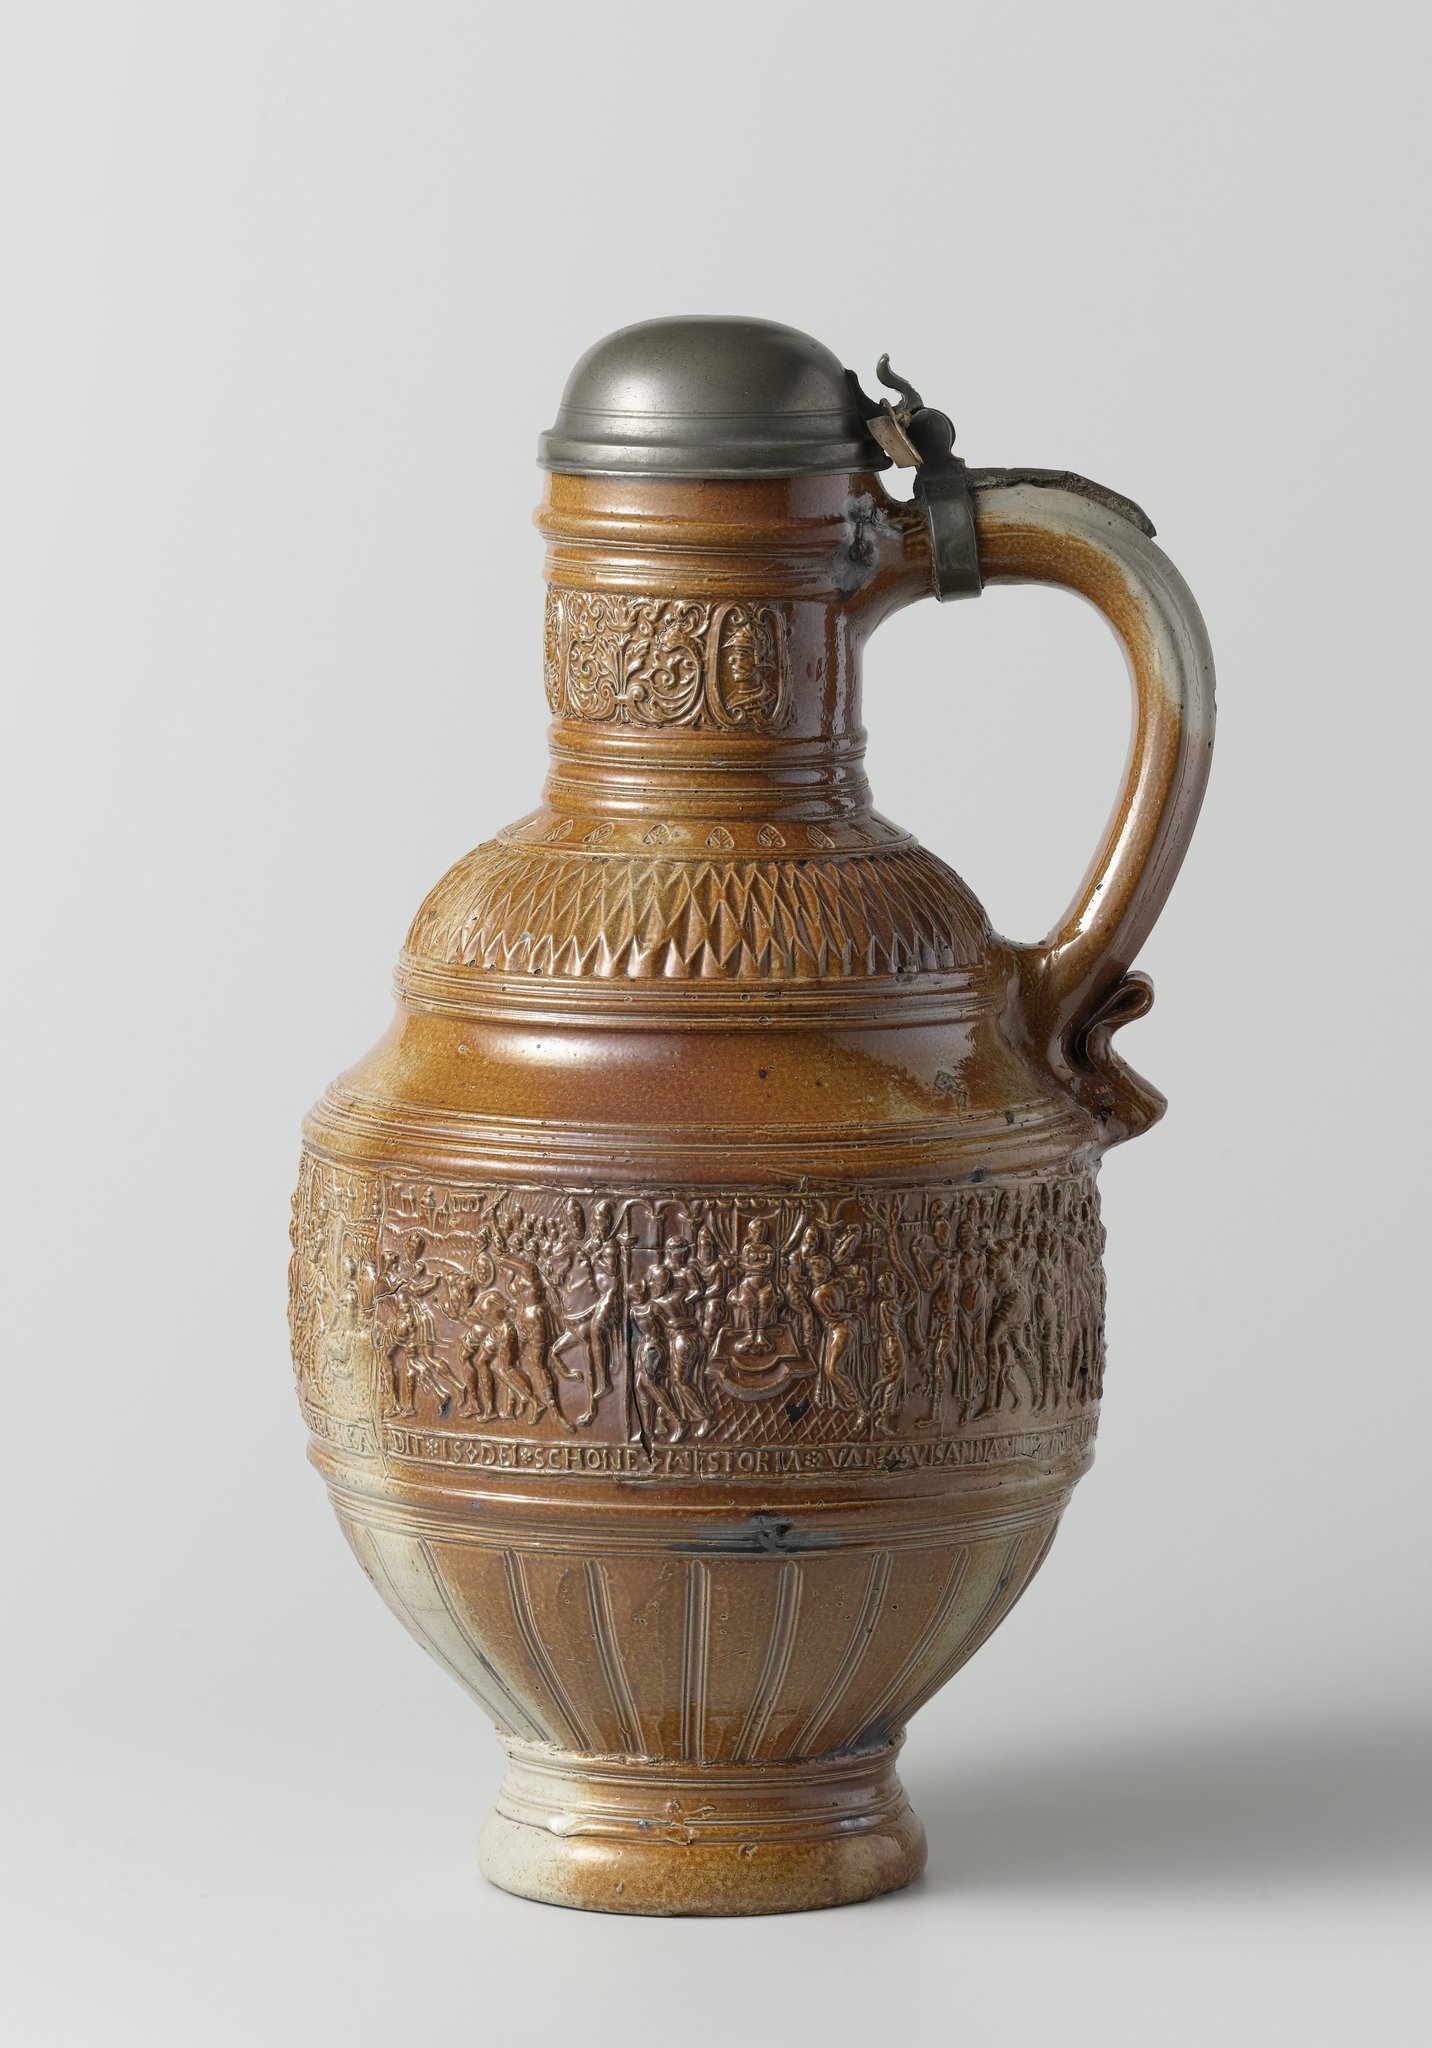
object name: jug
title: Jug with the Story of Susanna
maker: engel kran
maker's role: potter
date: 1584-1600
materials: engobe, glaze, stoneware, tin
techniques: printing, firing, forming, relief, turning, vitrification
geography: raeren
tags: the story of susanna and the elders (in which the youth daniel intervenes on behalf of susanna) (daniel 13)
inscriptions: date: ‘1584’, inscription: ‘DIT IS DEI SCHONE HESTORIA VAN SUISANNA INT KORTE EIT GESNEIDEN ANNO 1584 ENGEL KRAN’, signature: ‘ENGEL KRAN’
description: The body of this large pitcher is embellished with scenes from the story of the chaste Susanna. When the beautiful Susanna refused to submit to the dishonourable proposals of two elderly men, they accused her of adultery. However, the young Daniel exposed the two greybeards as liars. The two men suffered a gruesome death.